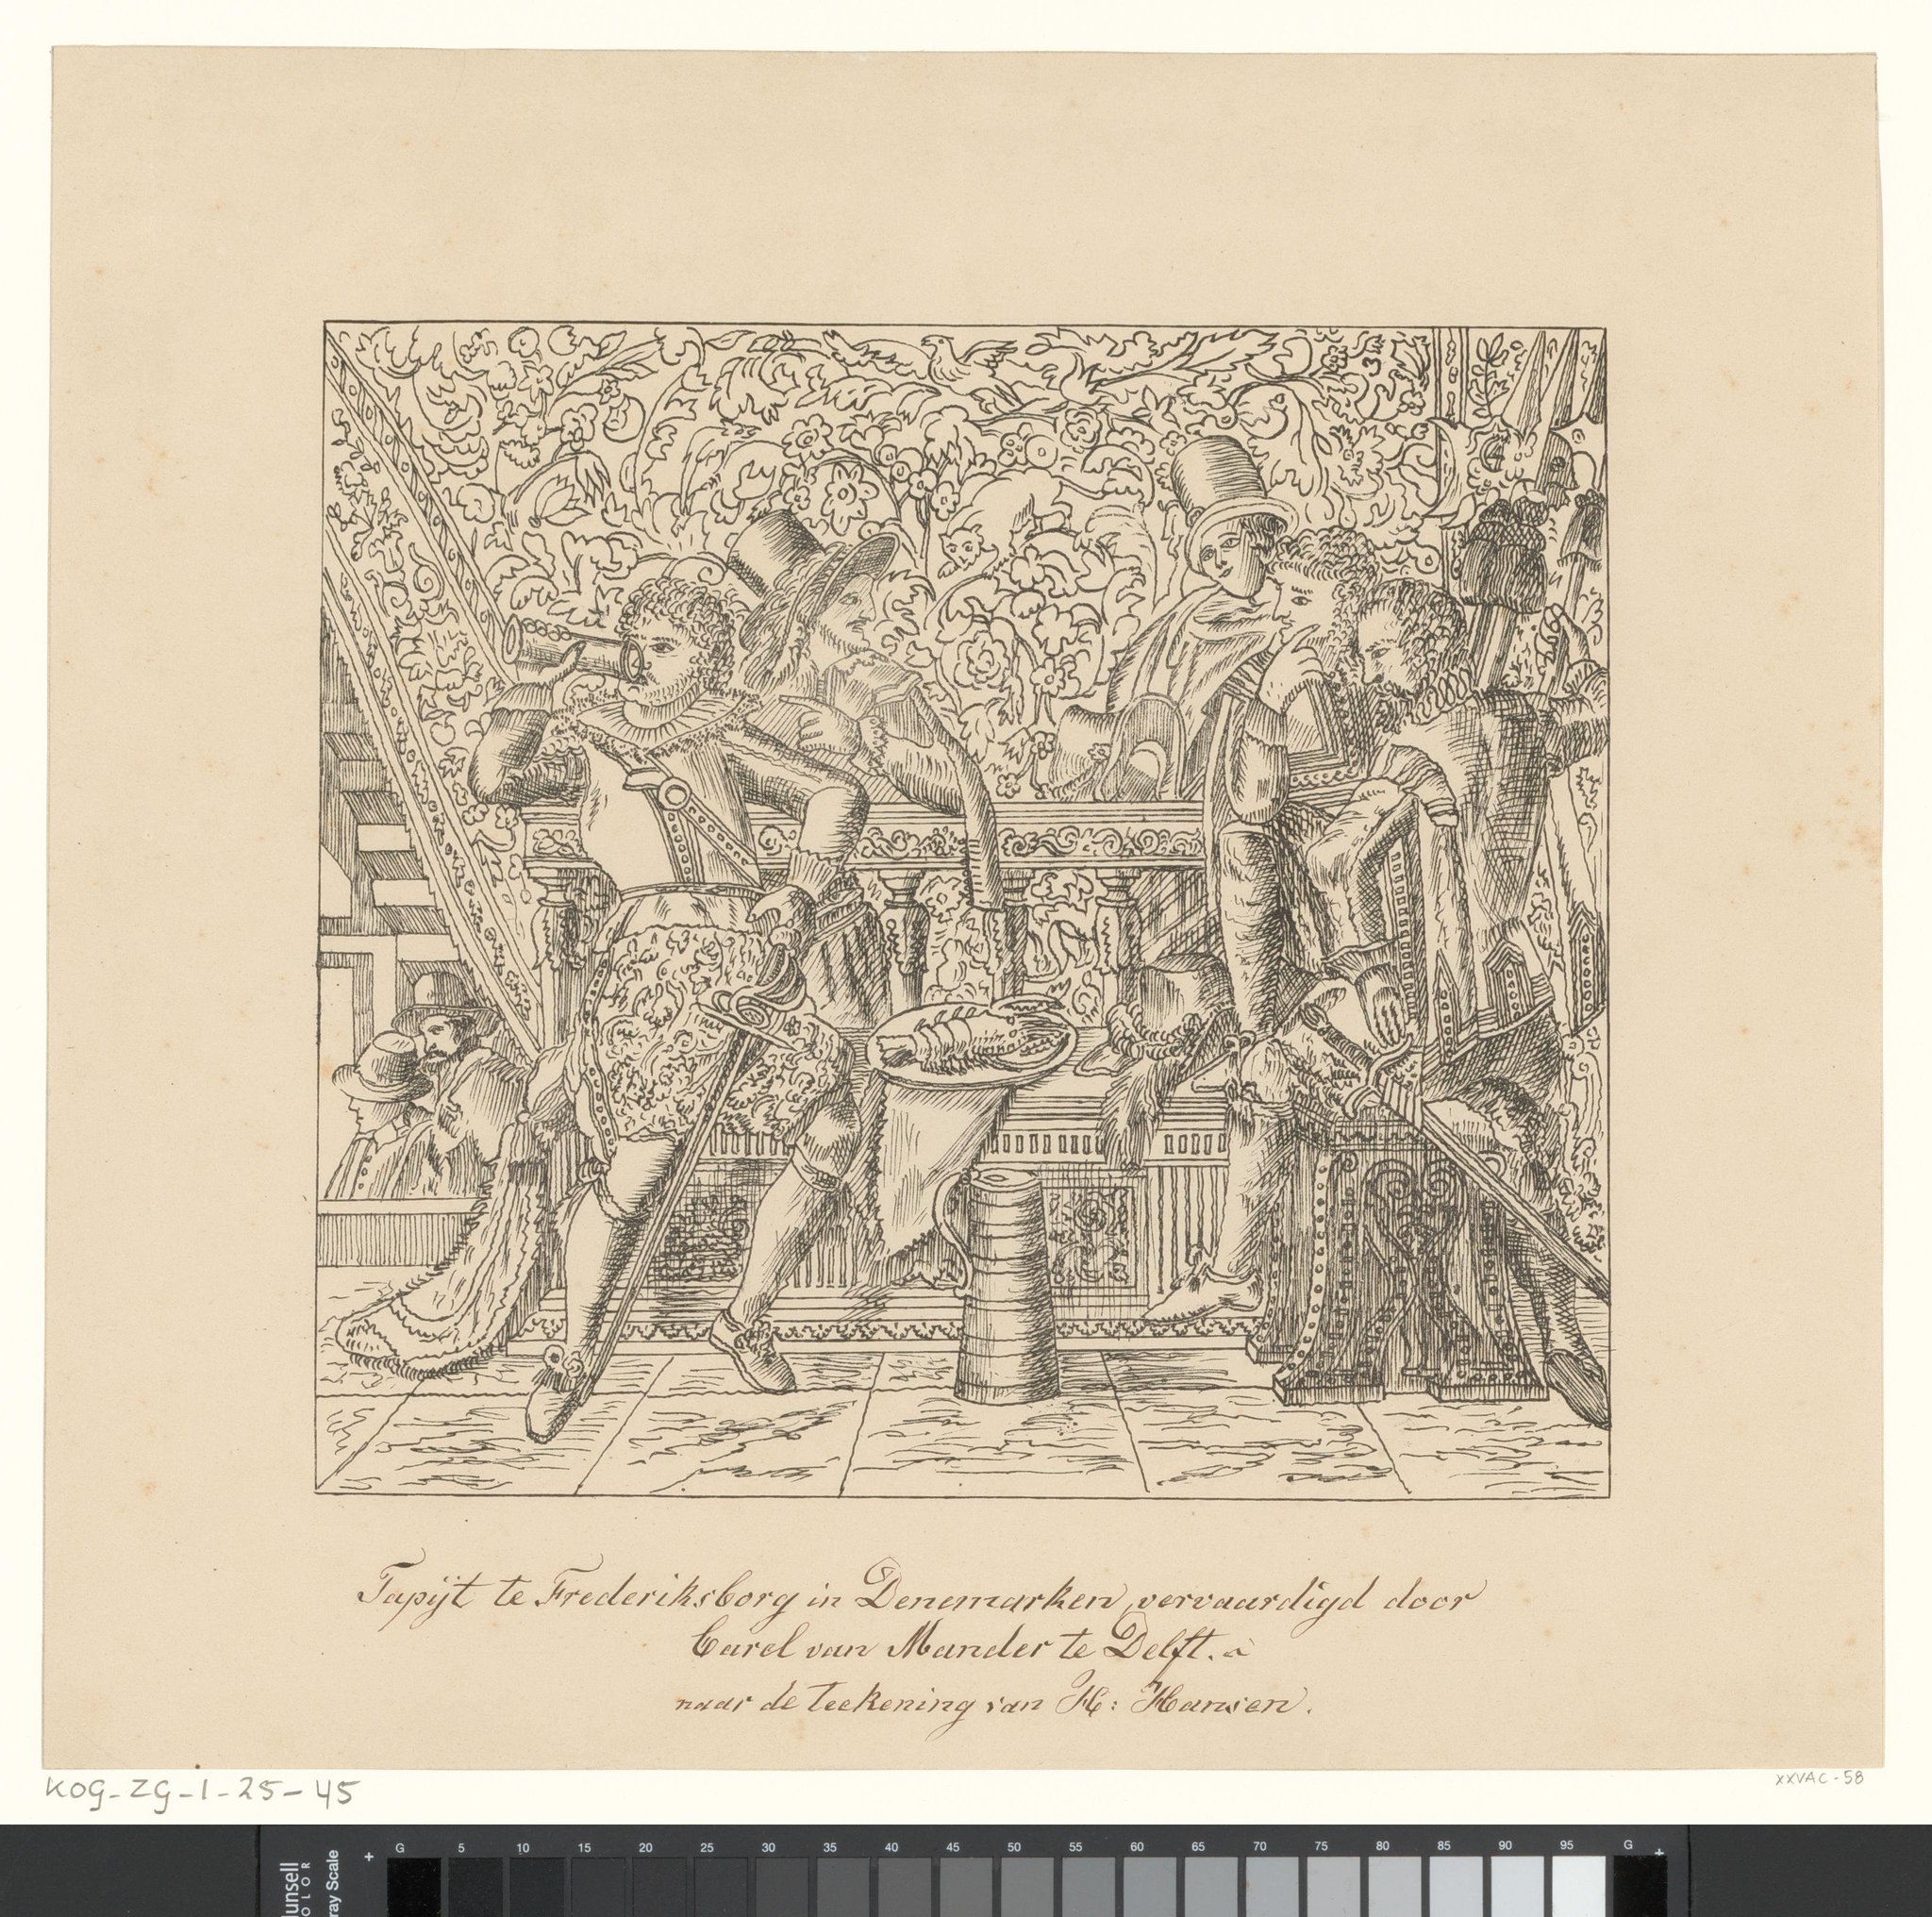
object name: print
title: Etende en drinkende mannen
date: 1870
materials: paper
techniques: lithograph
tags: christiaan iv (koning van denemarken en noorwegen), eating and drinking, drinking, crustaceans: lobster, eating, delft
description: Naar een tapijt uit Frederiksborg. Onderwerpsrubrieken binnen de Atlas Zeden en Gewoonten: Zeden en Gewoonten in Engeren Zin, De Woning, Binnenhuizen, Wandversiering.